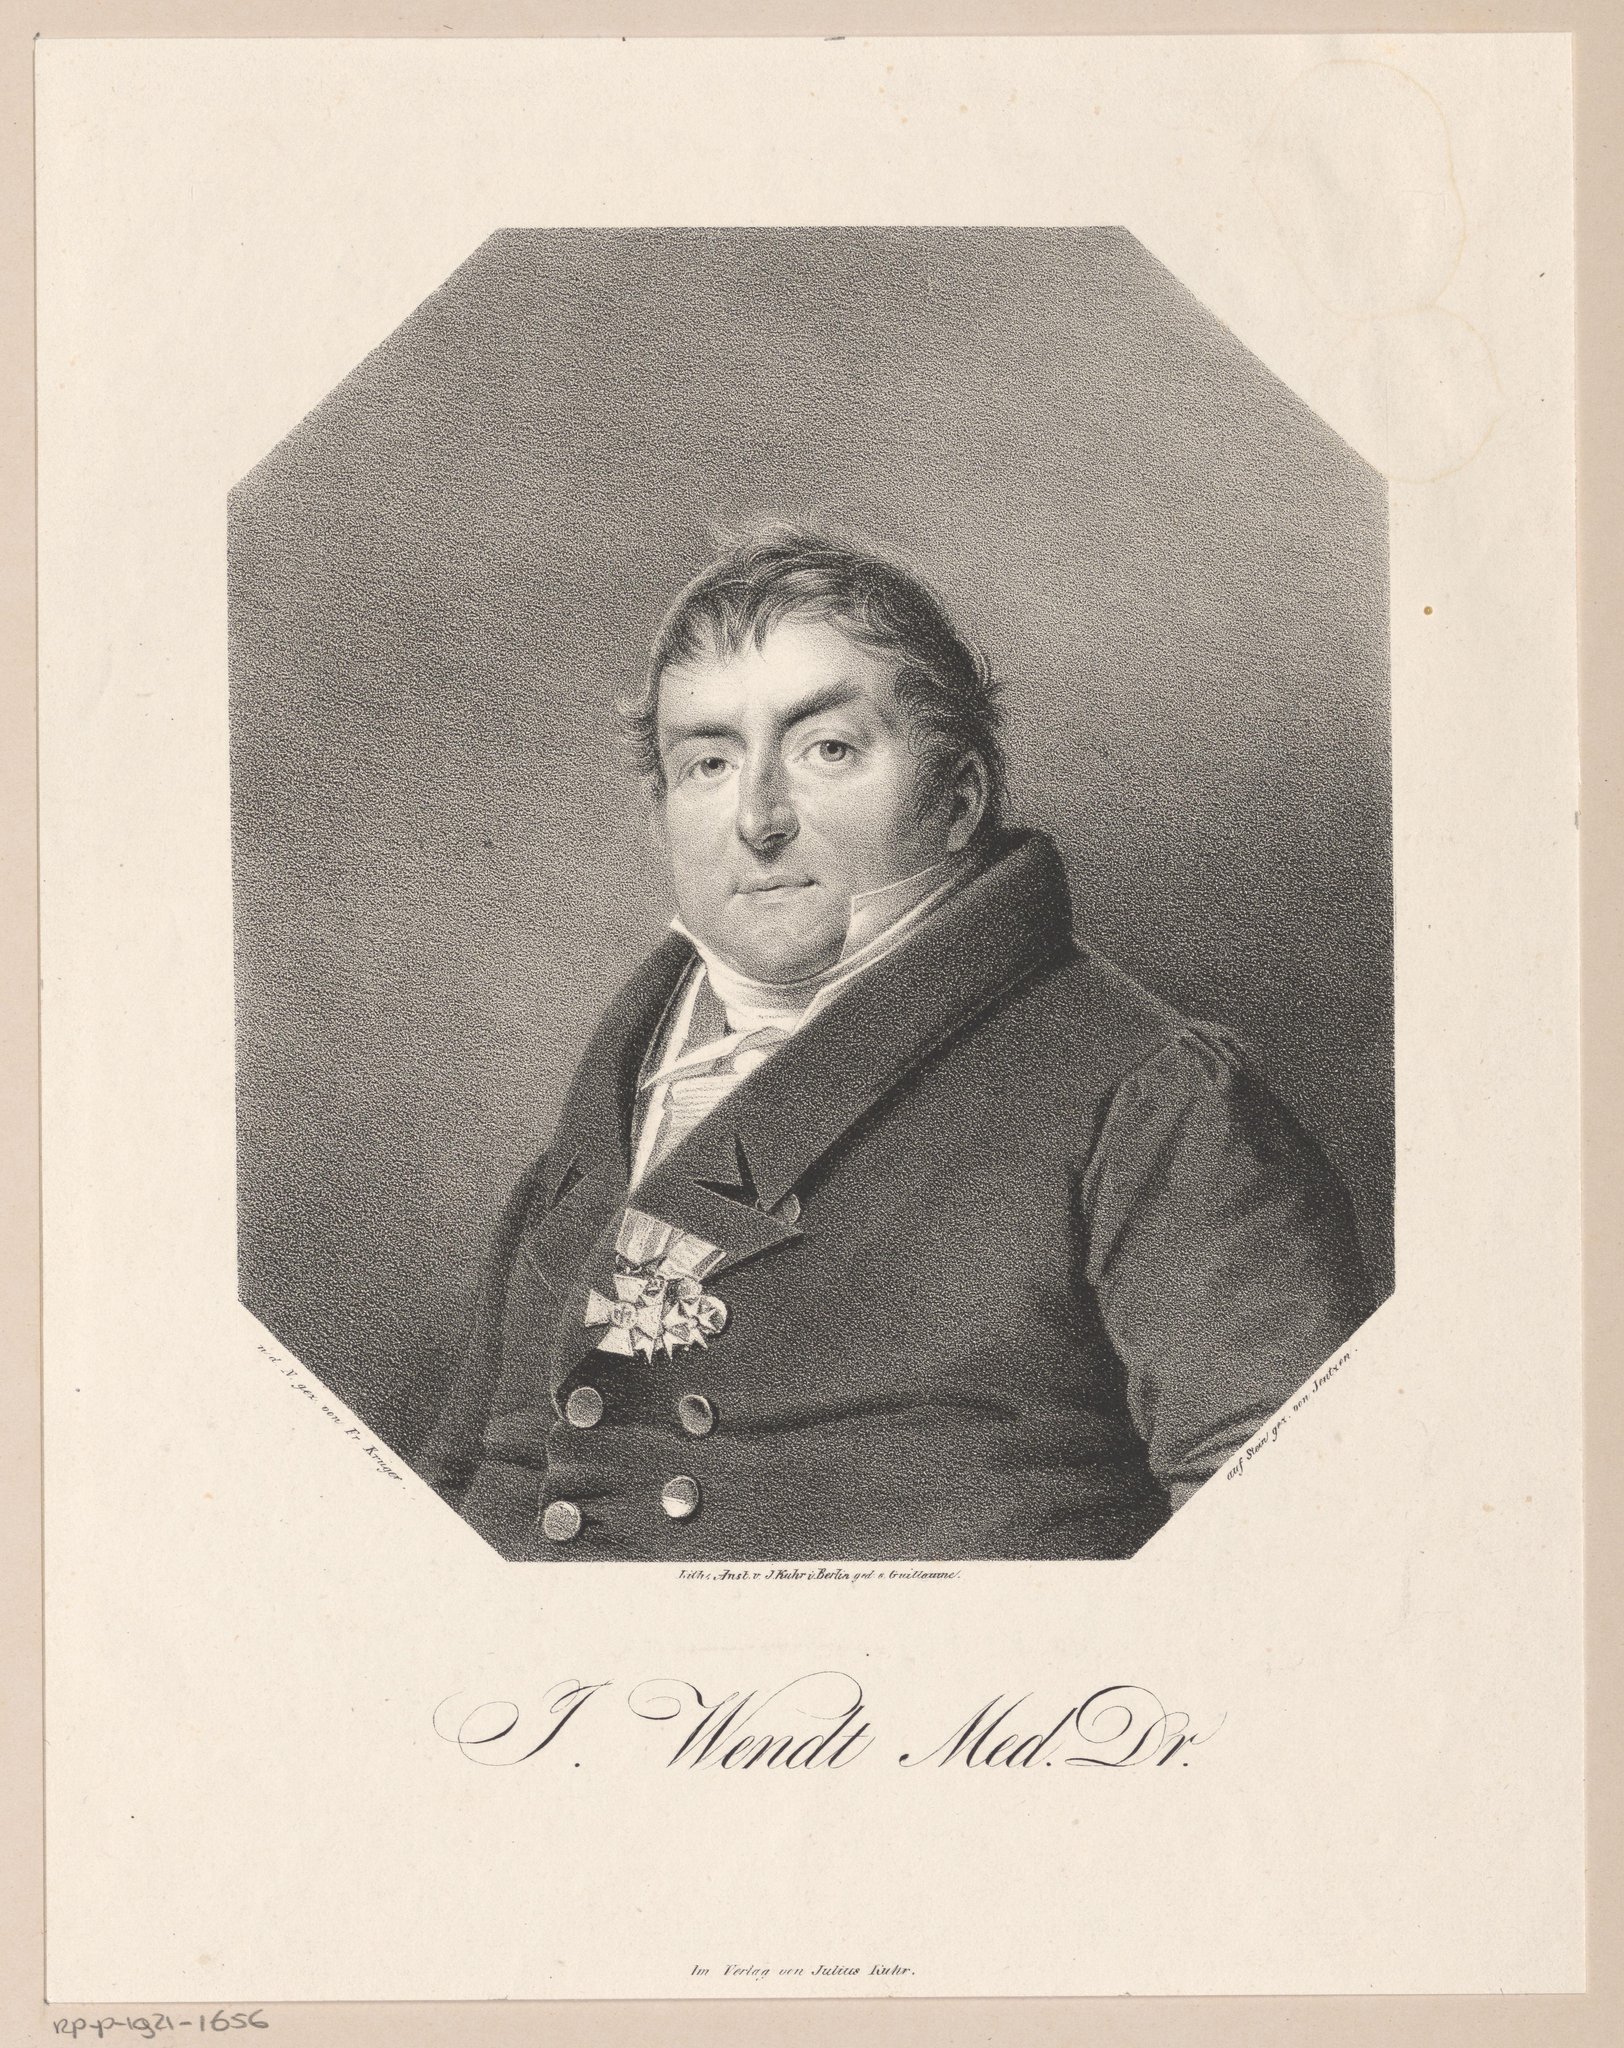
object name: print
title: Portret van Johann Wendt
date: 1820-1840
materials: paper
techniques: lithograph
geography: berlin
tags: historical persons, physician, doctor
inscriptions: collector's mark: Lugt 2233